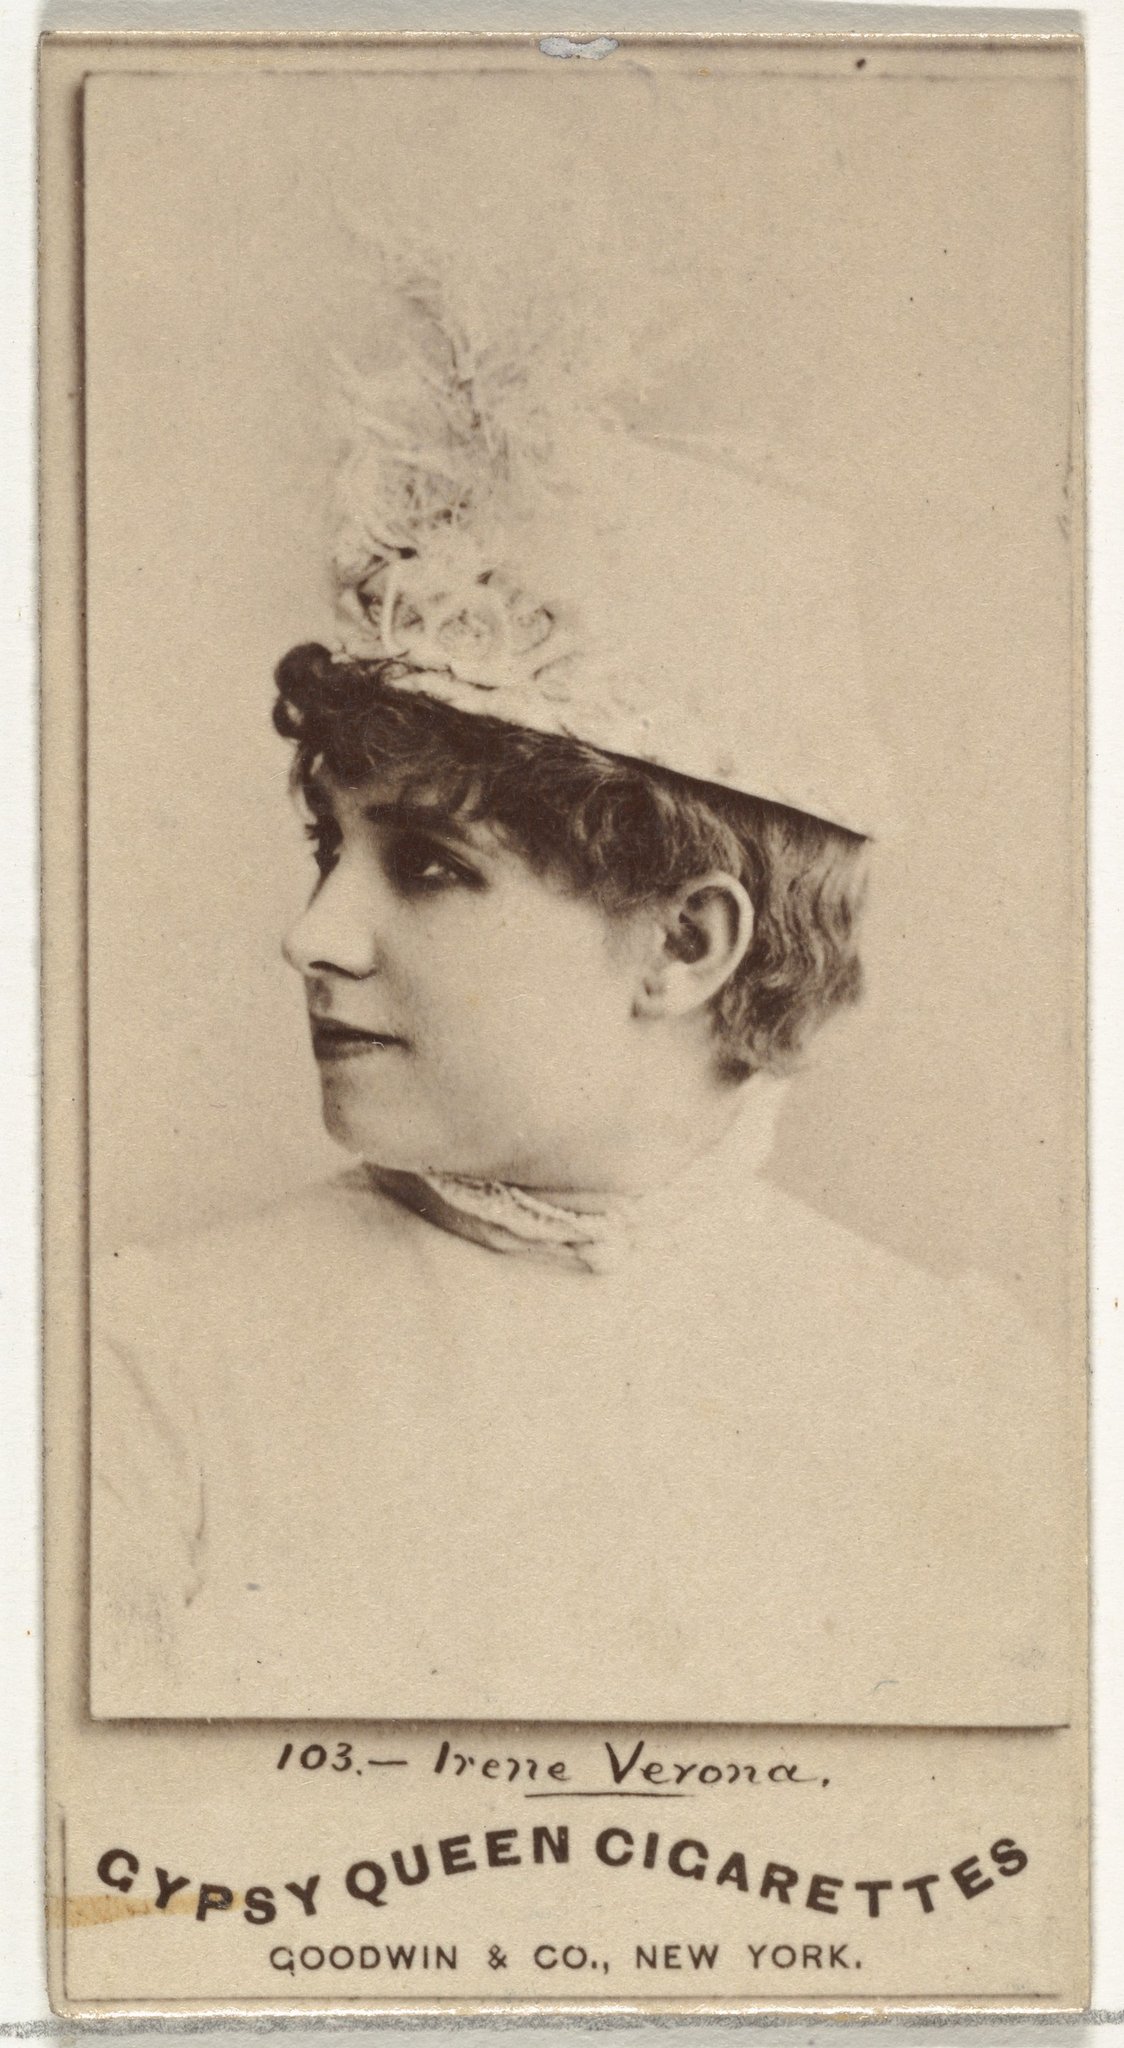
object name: photograph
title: Irene Verona, from the Actors and Actresses series (N171) for Gypsy Queen Cigarettes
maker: goodwin & company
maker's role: publisher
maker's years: 1850-1950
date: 1886-1890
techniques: albumen silver print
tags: portraits,women,actresses